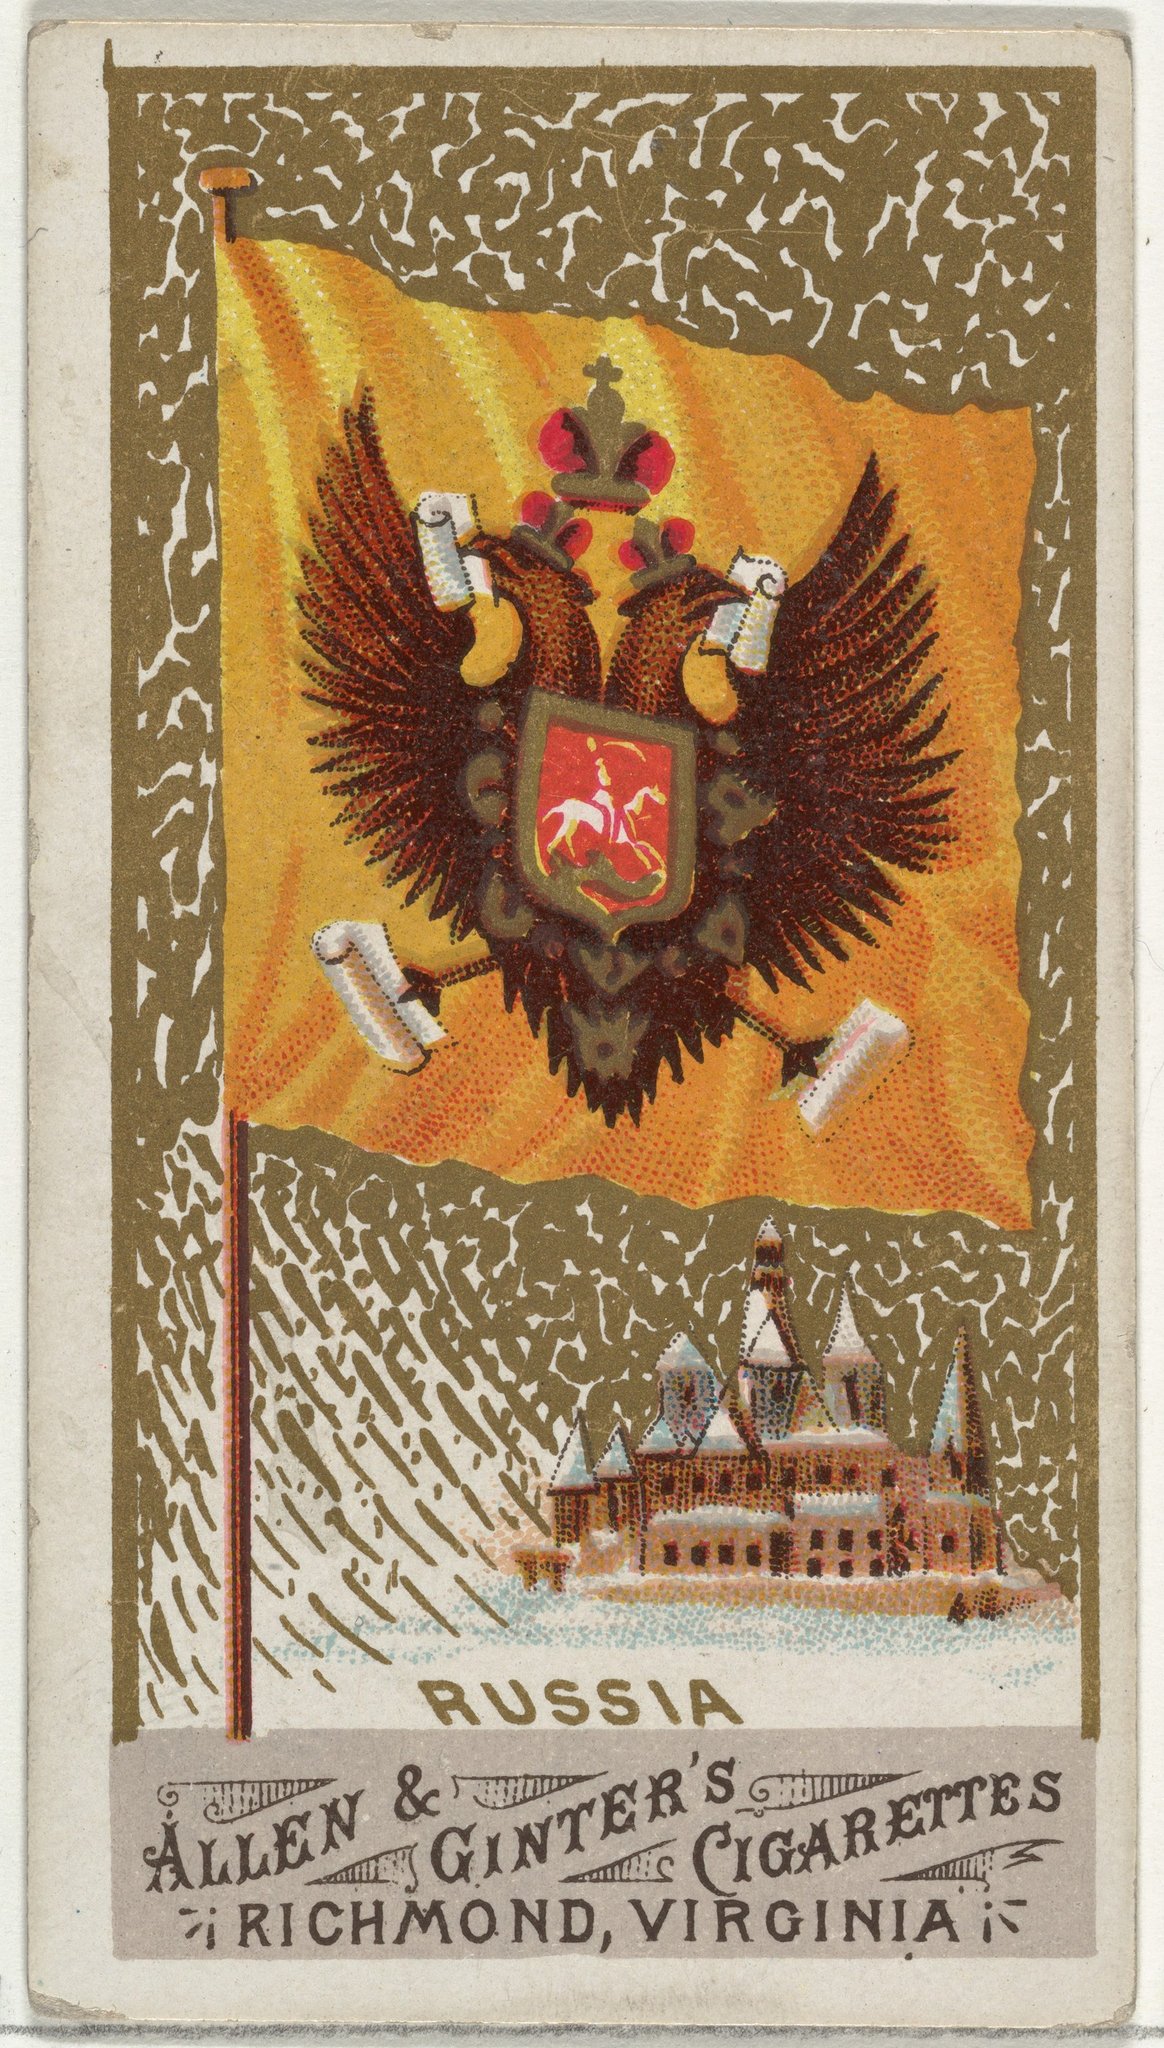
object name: print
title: Russia, from Flags of All Nations, Series 1 (N9) for Allen & Ginter Cigarettes Brands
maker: allen & ginter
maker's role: publisher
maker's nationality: american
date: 1887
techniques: color lithograph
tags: coat of arms,flags